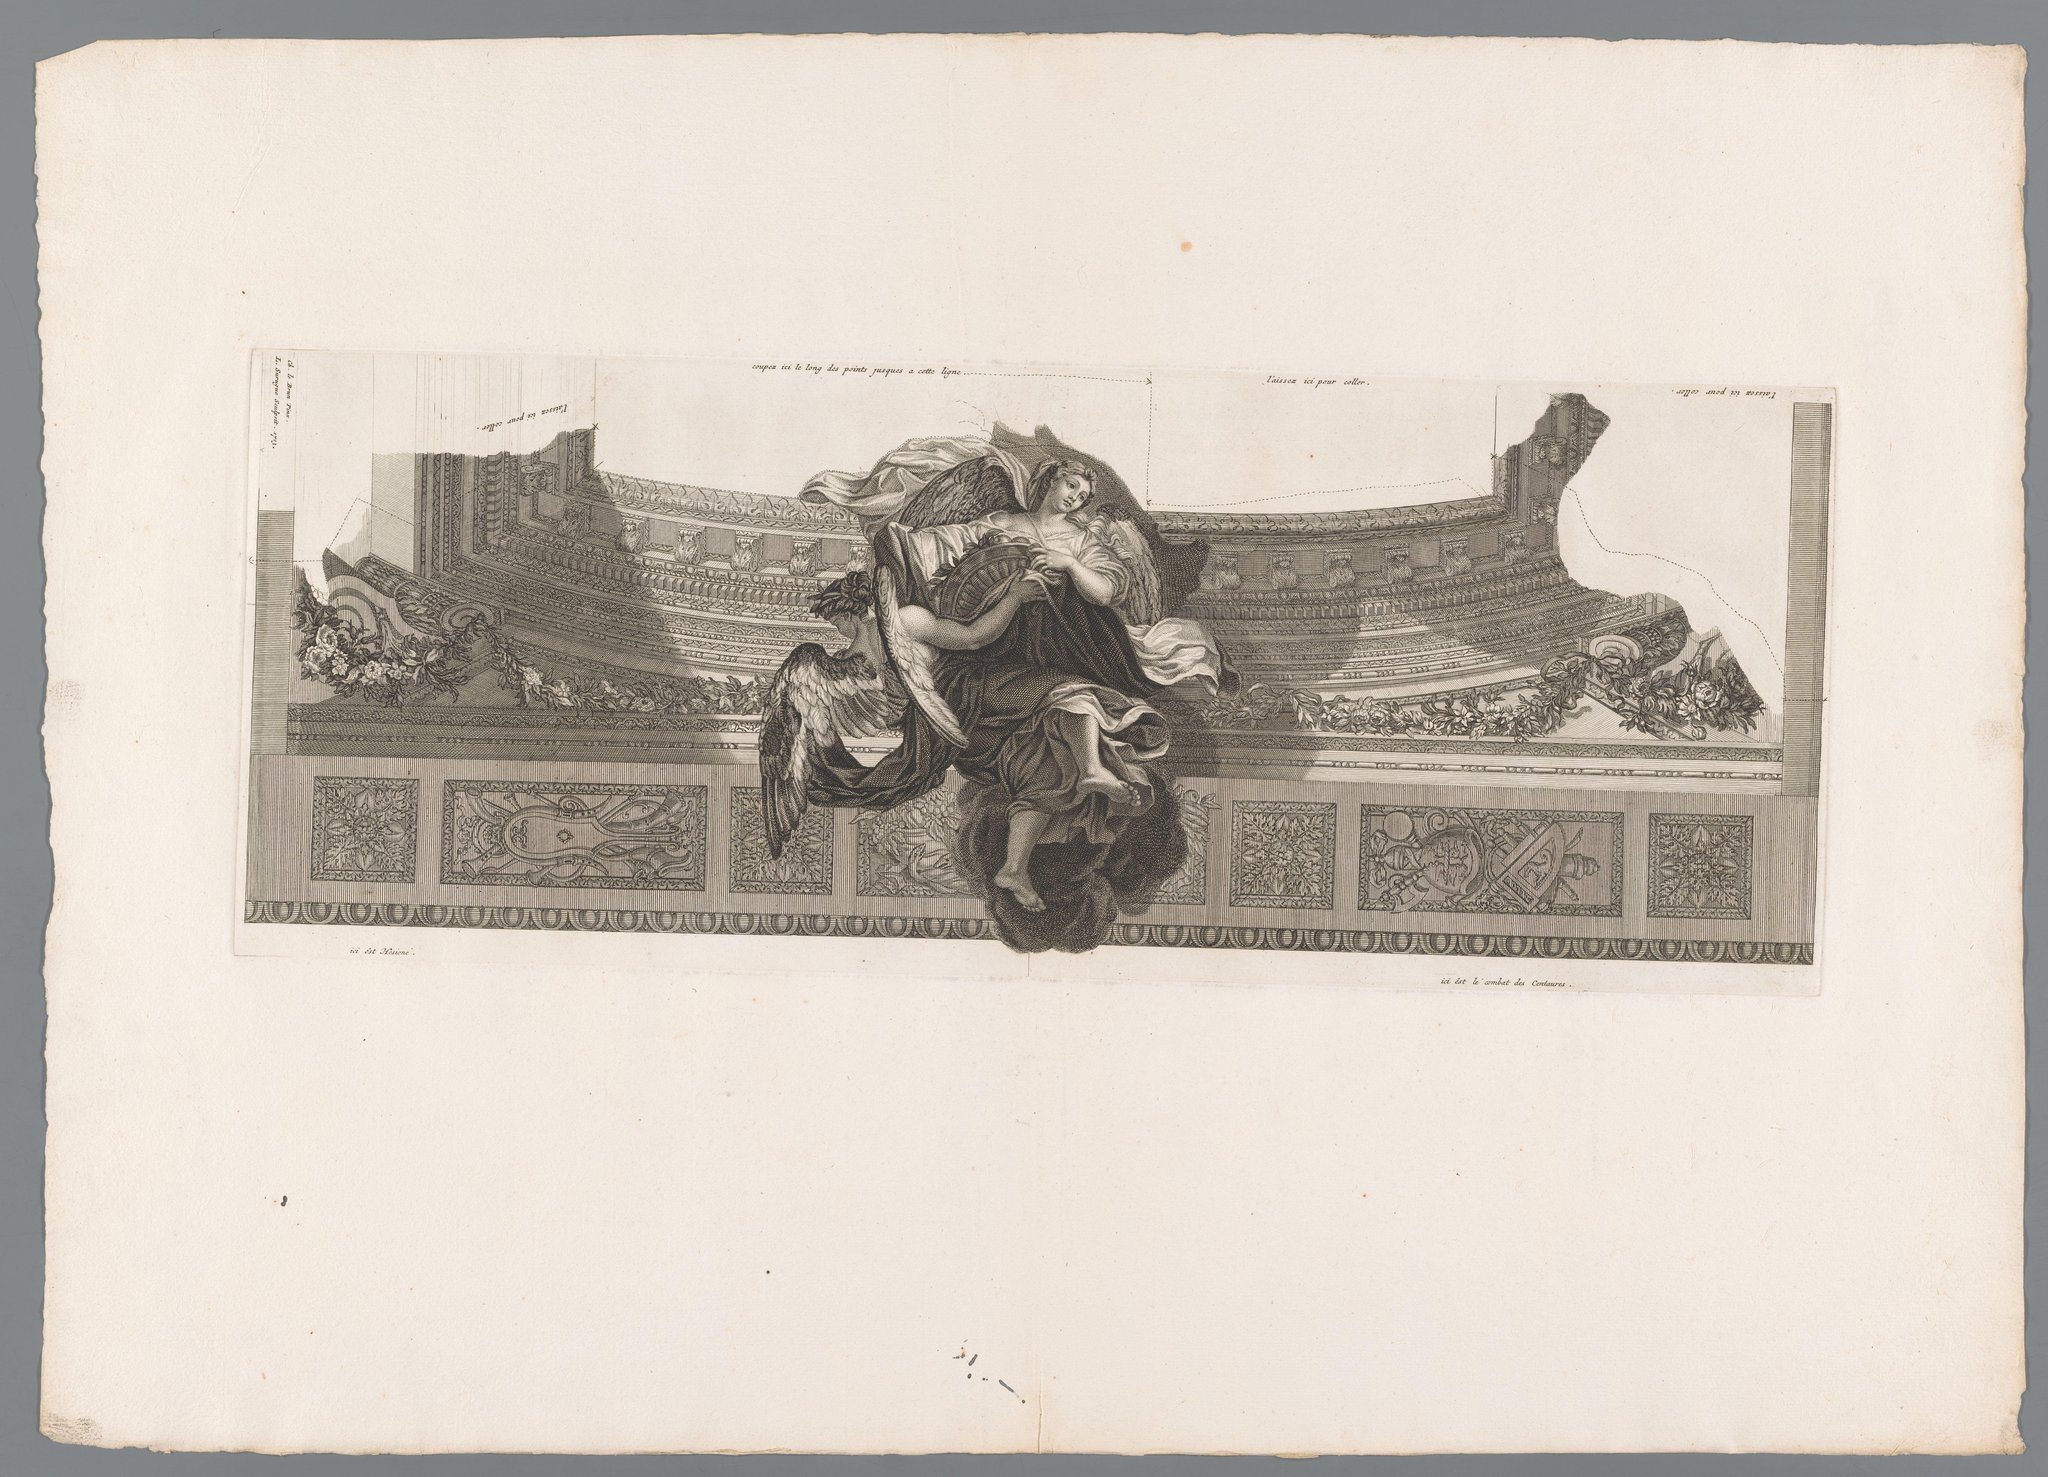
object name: print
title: La galerie de monsr. le president Lambert representant l'Apotheose d'Hercule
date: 1713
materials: paper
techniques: engraving, etching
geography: amsterdam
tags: (story of) flora - offspring, companion(s), train etc., (decorated) ceiling, ornament ~ festoon, garland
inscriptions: collector's mark: Lugt 2228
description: Twee gevleugelde volgelingen van Flora met een mand met fruit. Achter hen hangt aan het ornamentele plafond een festoen van bloemen. Langs de randen instructies voor het monteren van de prent aan andere prenten. Prent maakt deel uit van een serie prenten, die samen het geschilderde plafond met de Apotheose van Hercules in het Hôtel Lambert te Parijs voorstellen.